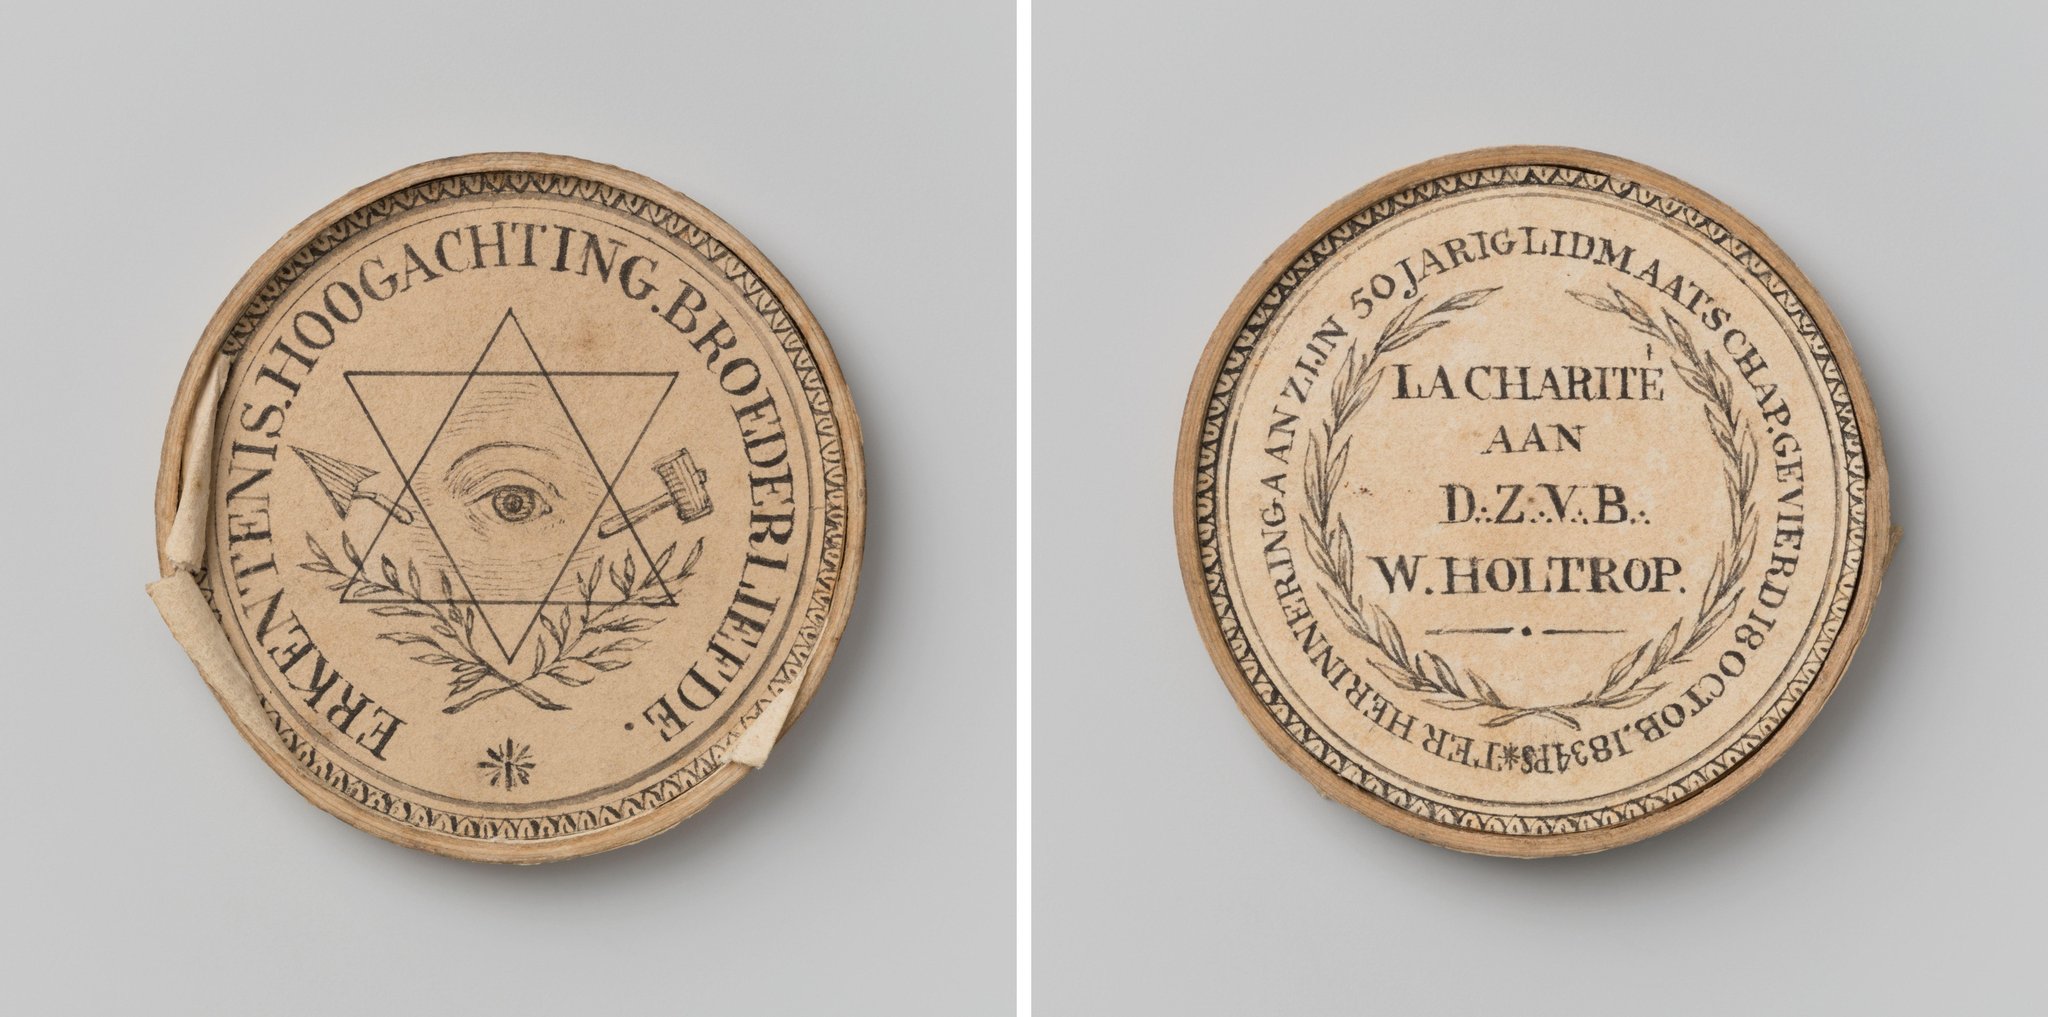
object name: honorary medal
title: Loge "La Charite", penning uitgereikt aan haar voorzitter Willem Holtrop ter ere van zijn vijftigjarig lidmaatschap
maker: Anonymous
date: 1834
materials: cardboard, paper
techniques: striking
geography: netherlands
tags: willem holtrop, amsterdam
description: Papieren penning. Voorzijde: alziend oog in midden van twee elkaar overlappende driehoeken tussen troffel en hamer, boven twee gekruiste lauwertakken en ster binnen omschrift. Keerzijde: opschrift binnen lauwerkrans, omschrift en sierrand.